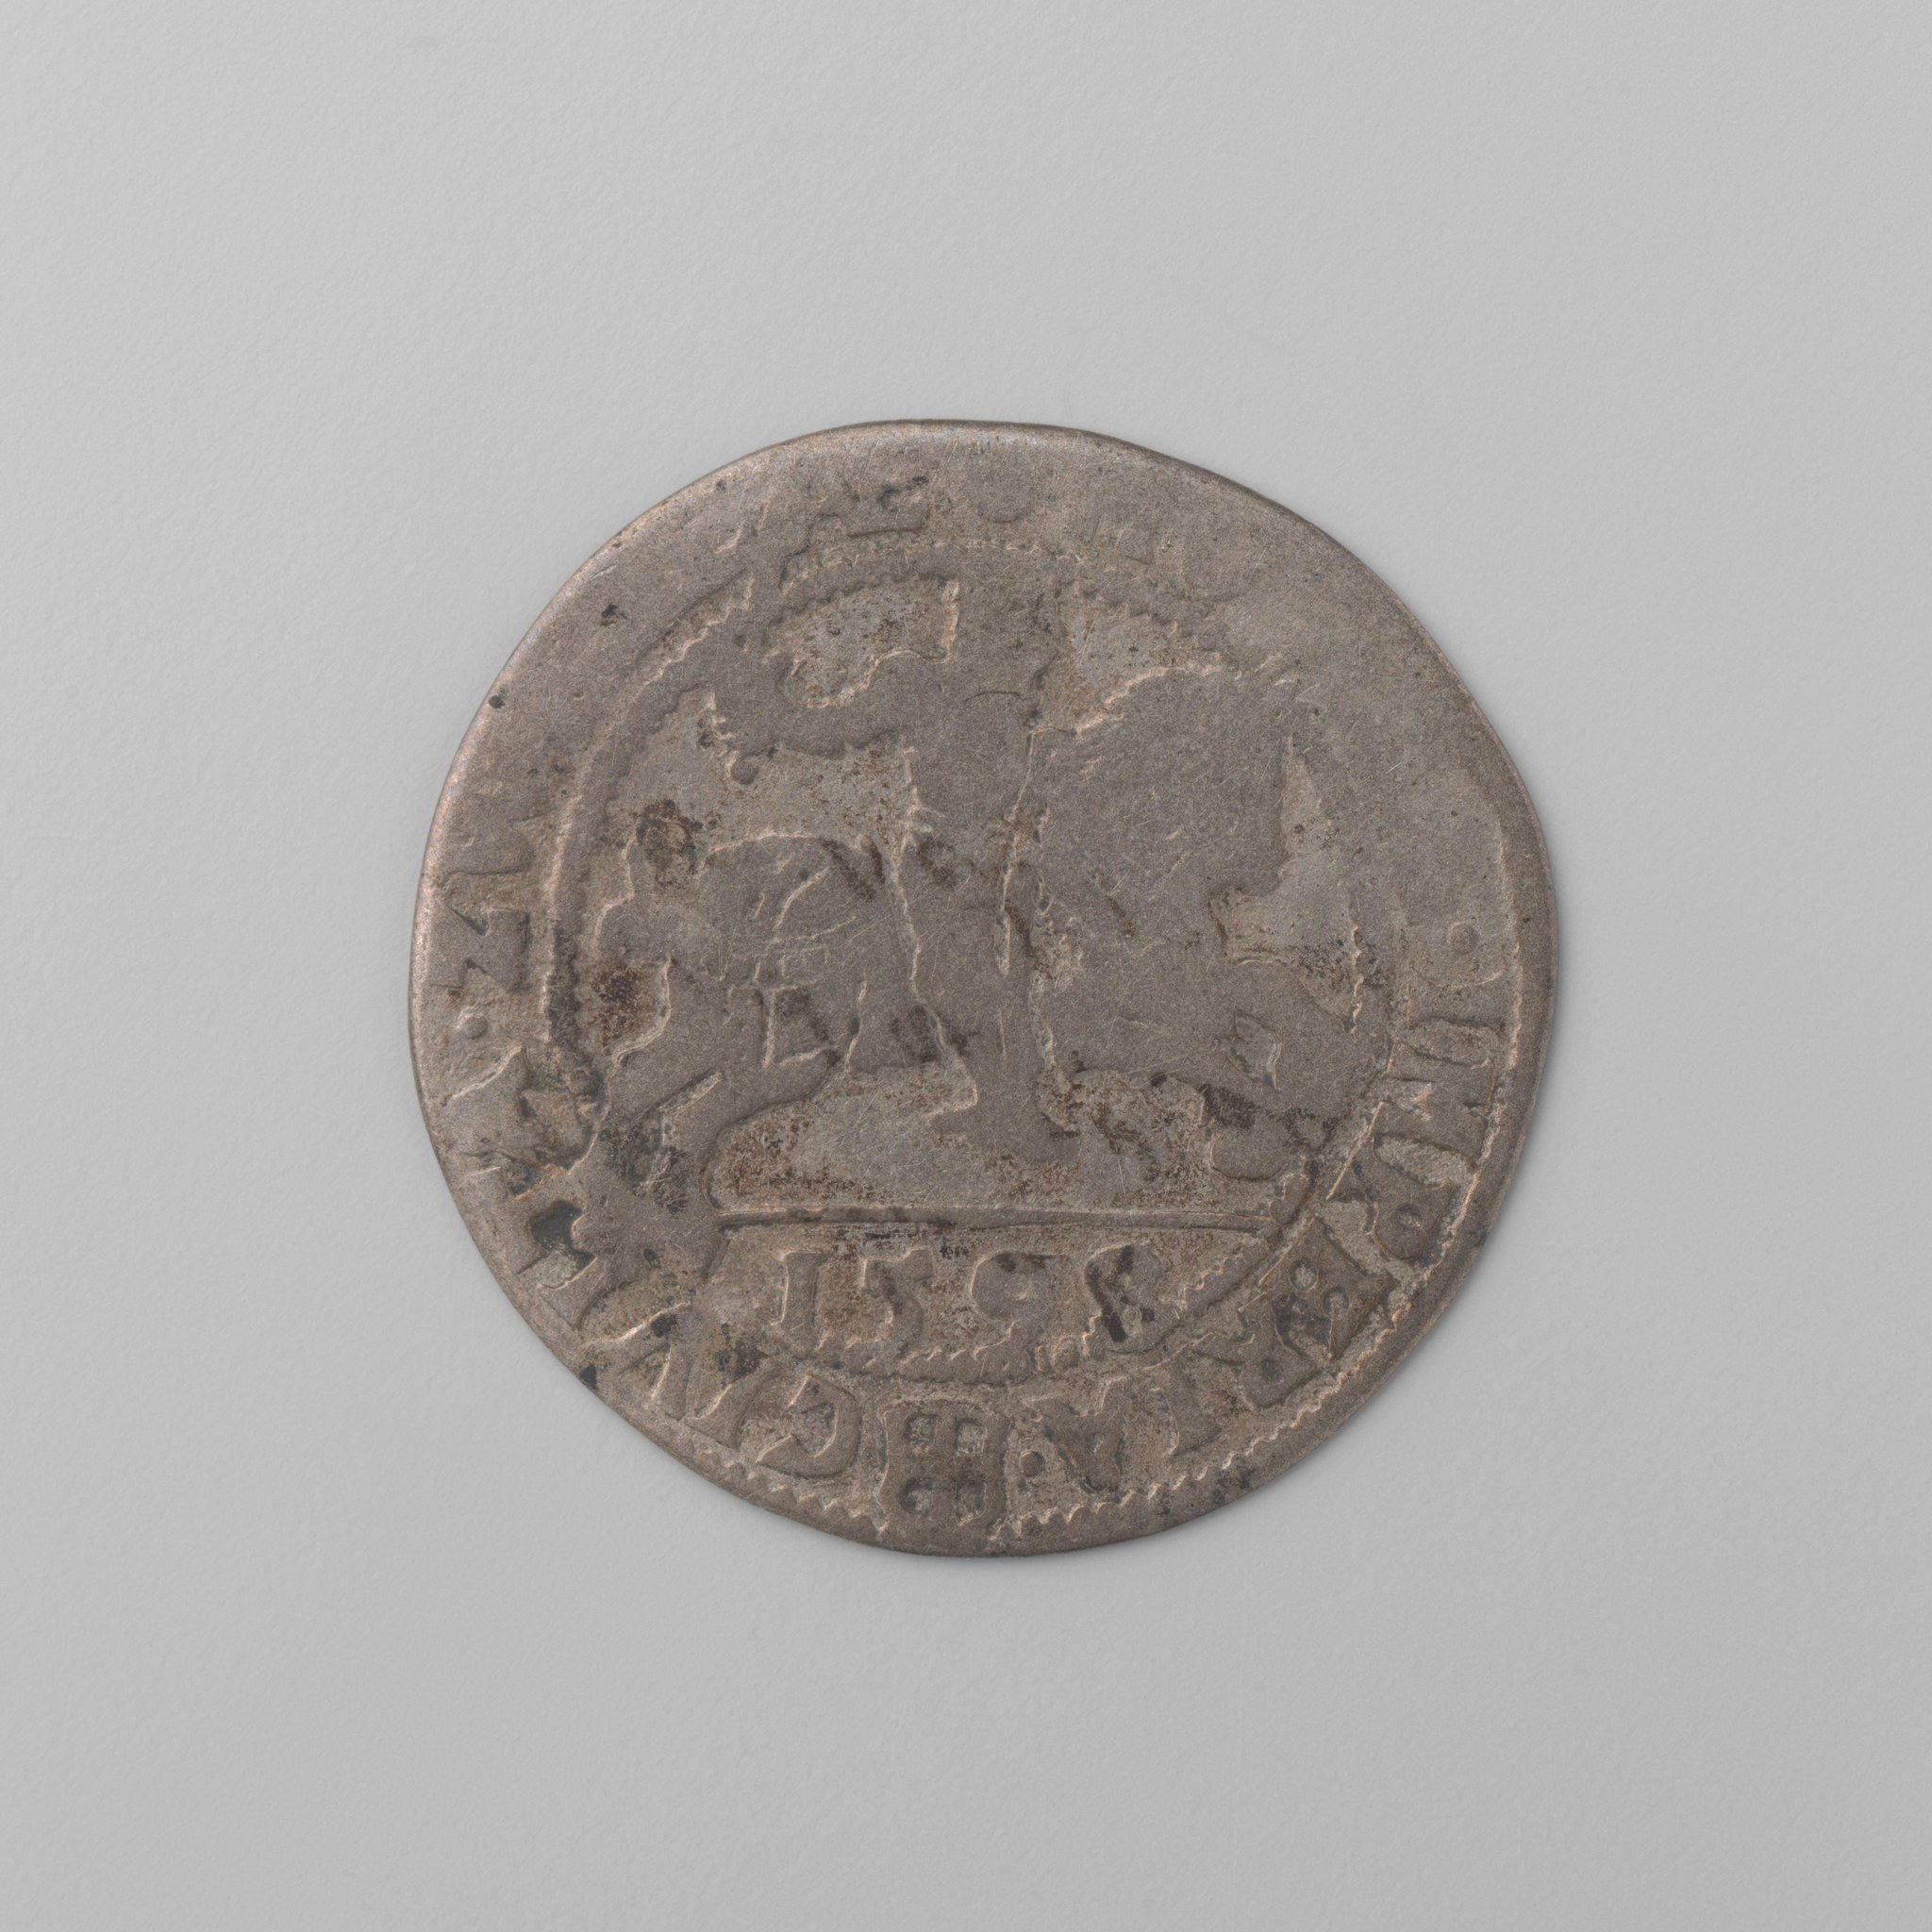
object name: coin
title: Zwolse halve snaphaanschelling, 1598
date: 1598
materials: silver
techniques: striking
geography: zwolle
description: Voorzijde: ridder te paard met zwaard naar rechts, in afsnede jaartal. Keerzijde: gekroonde dubbelkoppige adelaar met rijksappel waarin waarde-aanduiding 3.